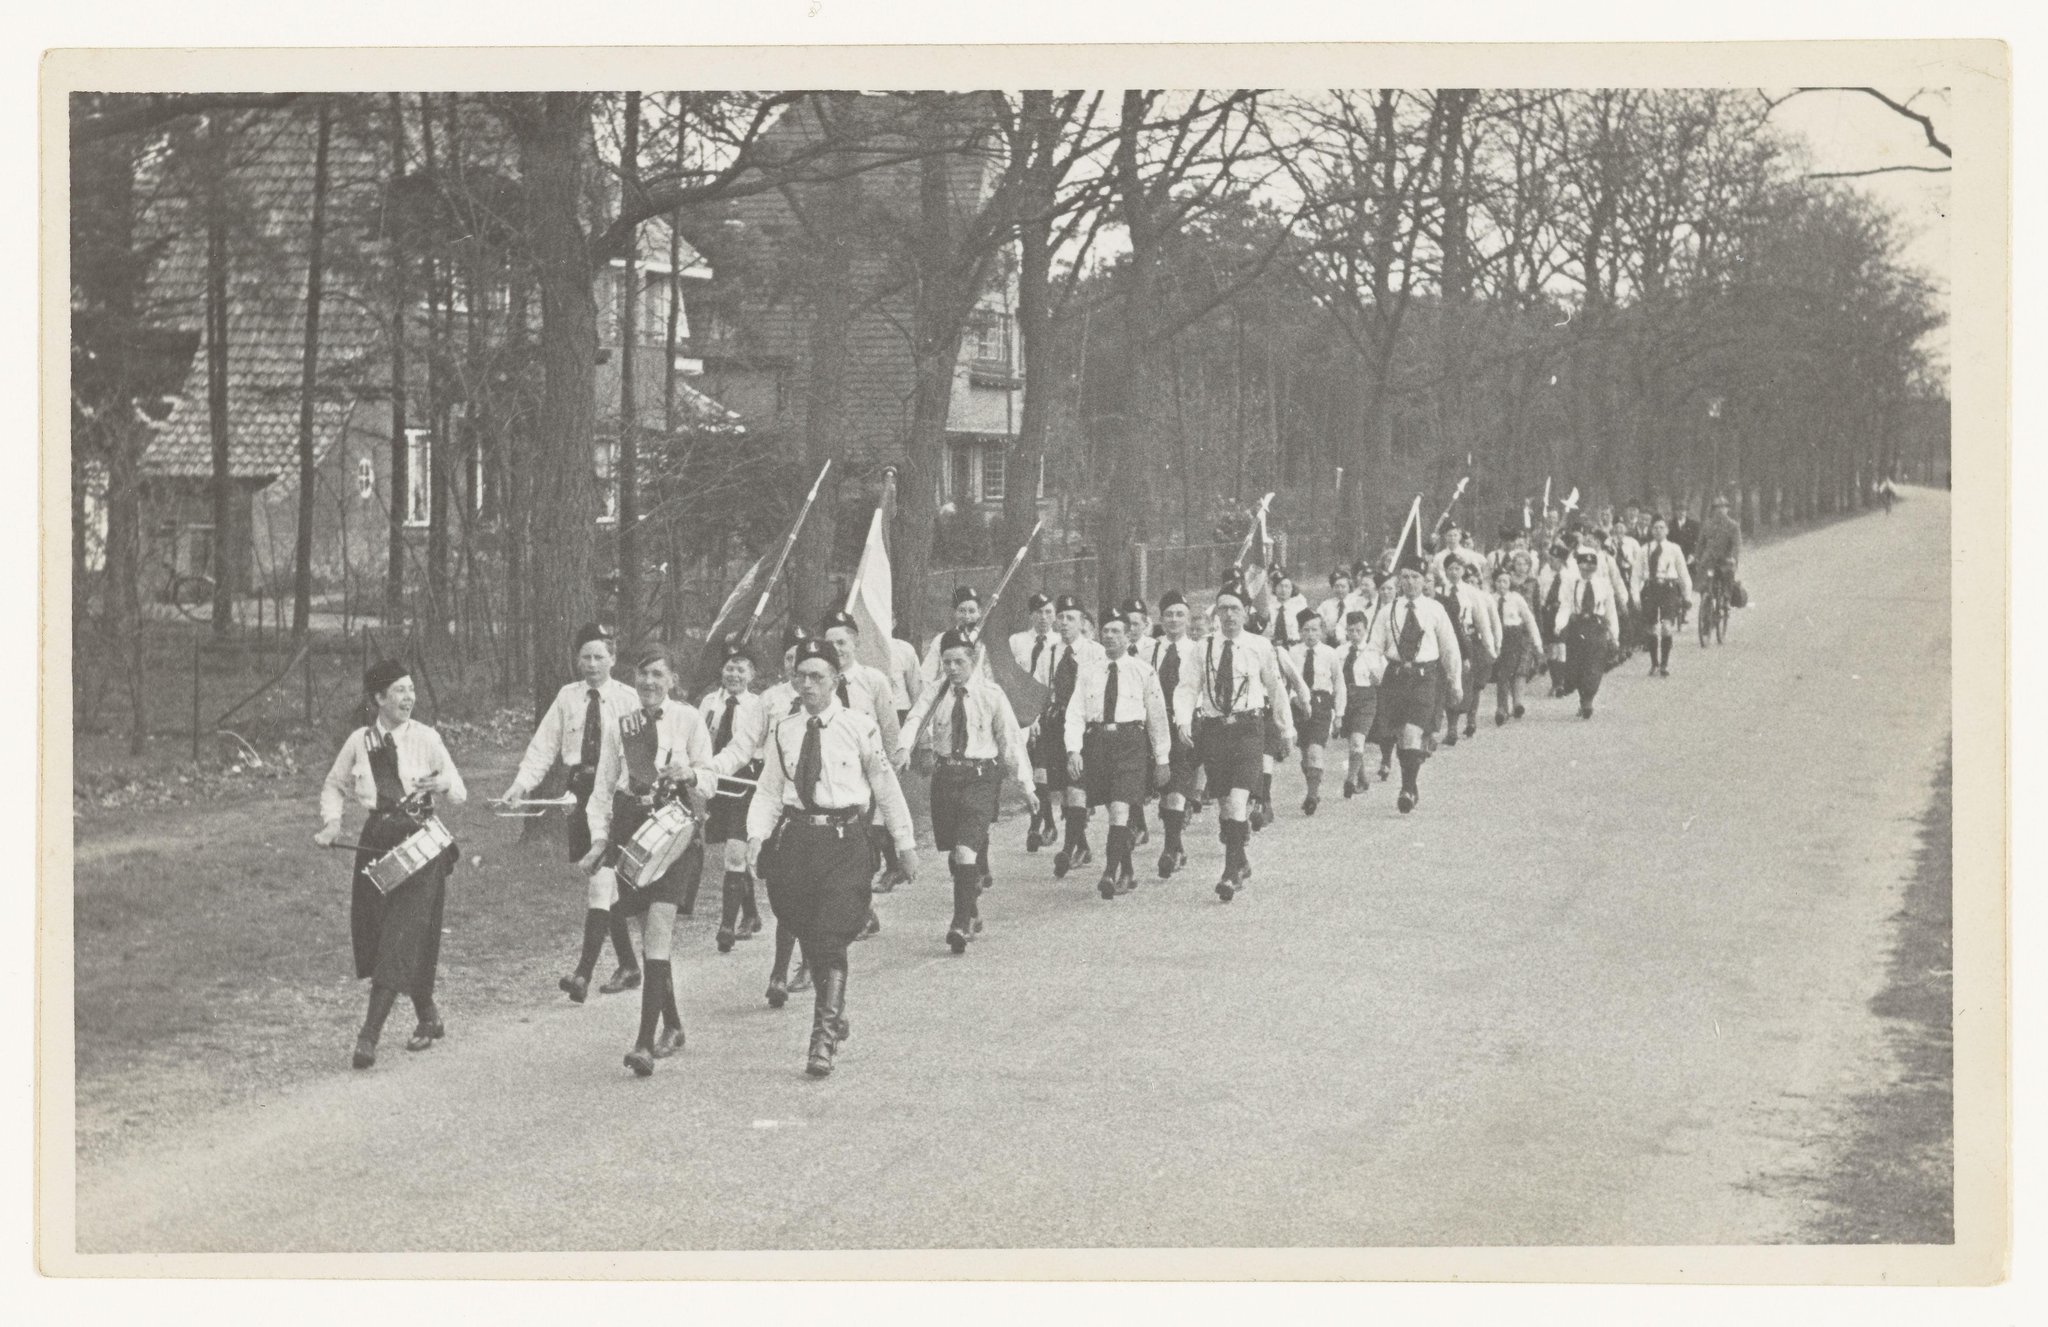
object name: photograph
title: Optocht Jeugdstorm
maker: j. otto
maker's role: fotograaf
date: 1935-1937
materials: photographic support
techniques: gelatin silver print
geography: zeist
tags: military parade, pageant, zeist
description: Groep van de Jeugdstorm loopt in uniform door een straat met hoge bomen. Voorop een jongen en meisje met trommel (en de fotograaf van de amateurfoto's) dan een groep jongens, erachter de meisjes. Er worden veel vlaggen meegedragen. Helemaal achteraan een paar mensen op de fiets. De leiders van de diverse groepen lopen naast de rij, zij dragen een koord (nestels) op hun overhemd.